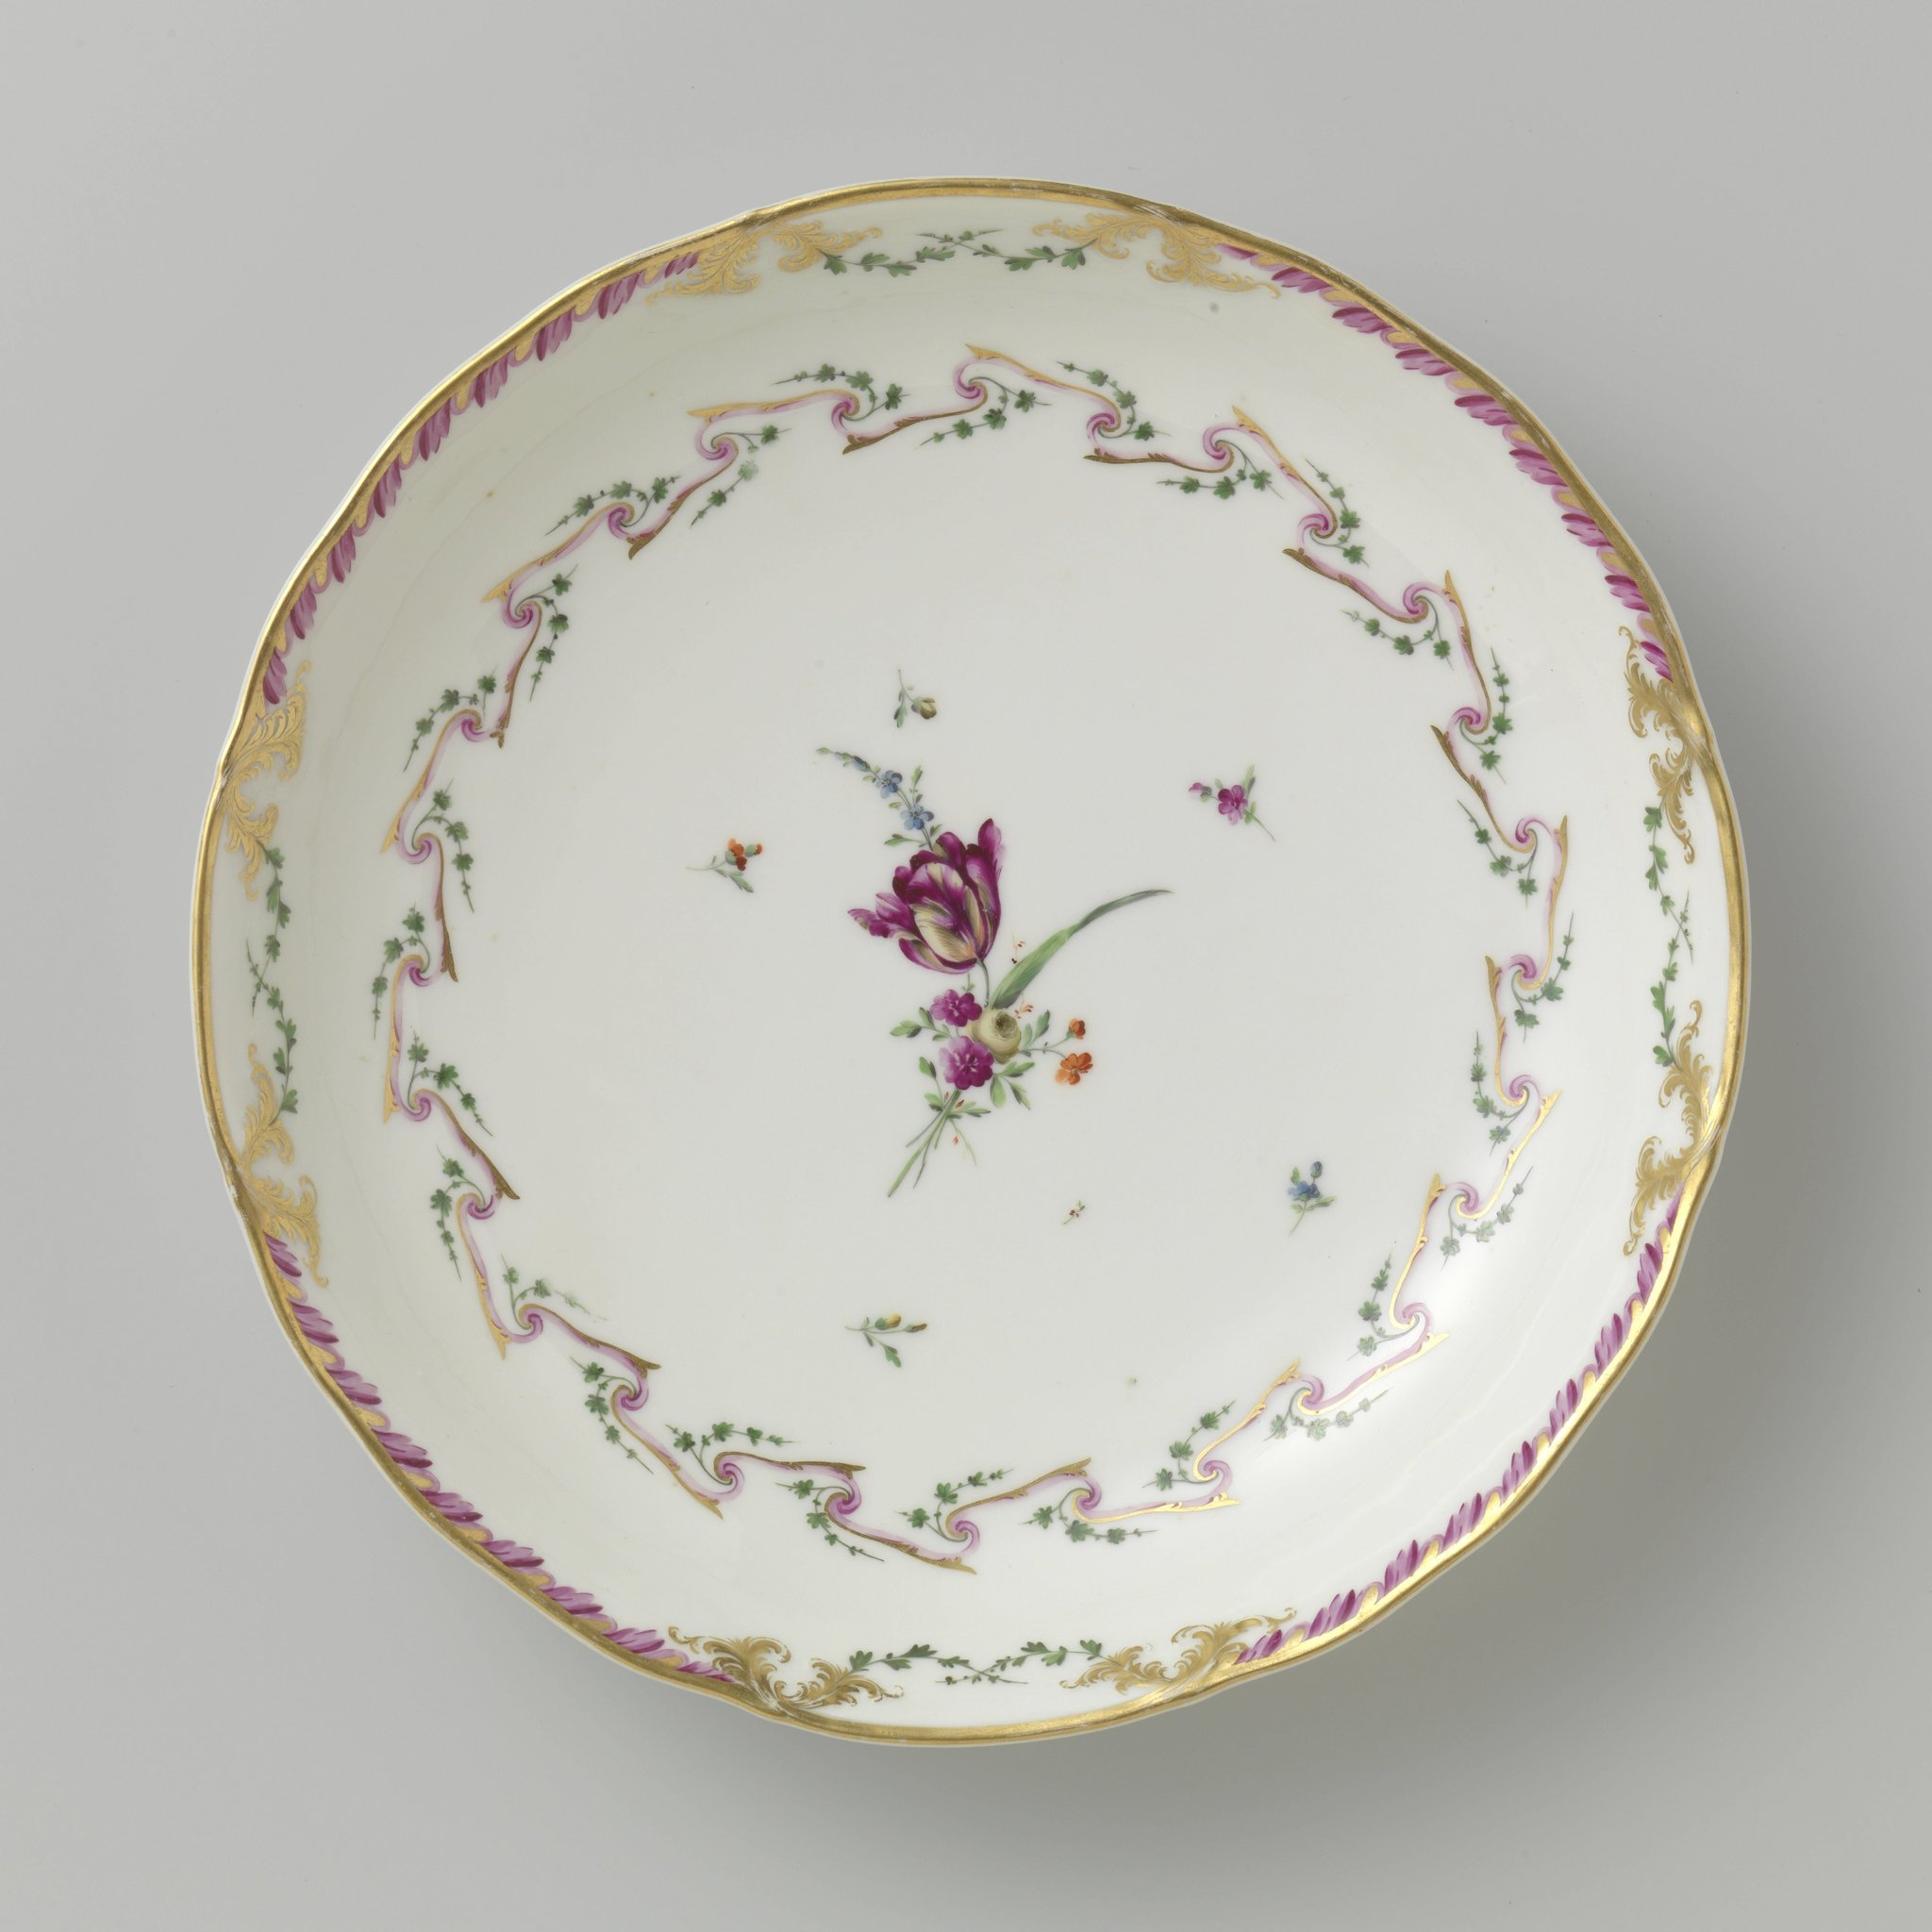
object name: dish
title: Schaal, rond en diep, behorend bij een servies versierd met geslingerd lintmotief met bladertakken, bloemboeketten en gestrooide bloemtakken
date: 1780-1820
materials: porcelain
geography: amsterdam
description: Schaal, rond en diep , behorend bij een servies van porselein versierd met een geslingerd lintmotief in paars en goud met groene bladertakken, bloemboeketten en gestrooide bloemtakken. Randen licht gegolfd, met decoratie in goud met paars bladmotief waartussen groen gekruist bladmotief. Gemerkt: M.O.L. en Amstel.